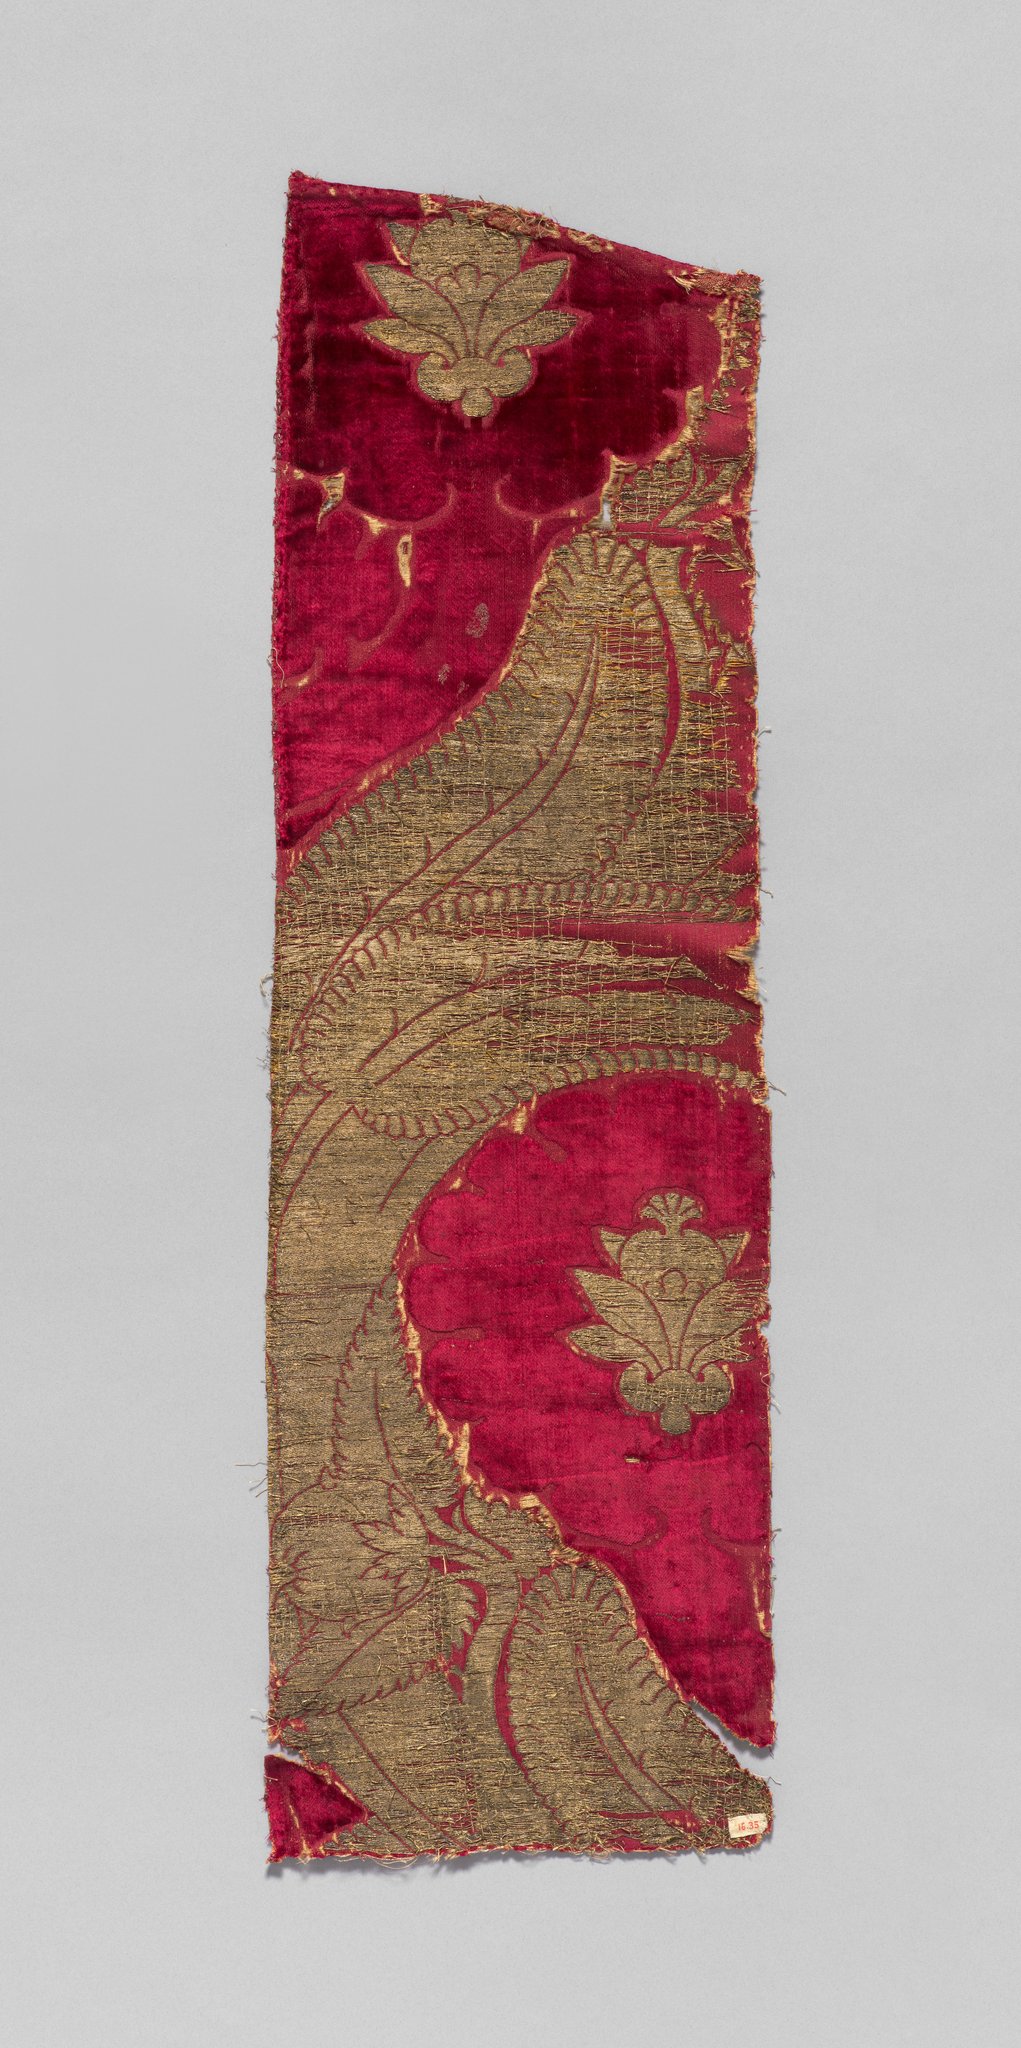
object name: piece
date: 1425-1450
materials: metal thread, silk